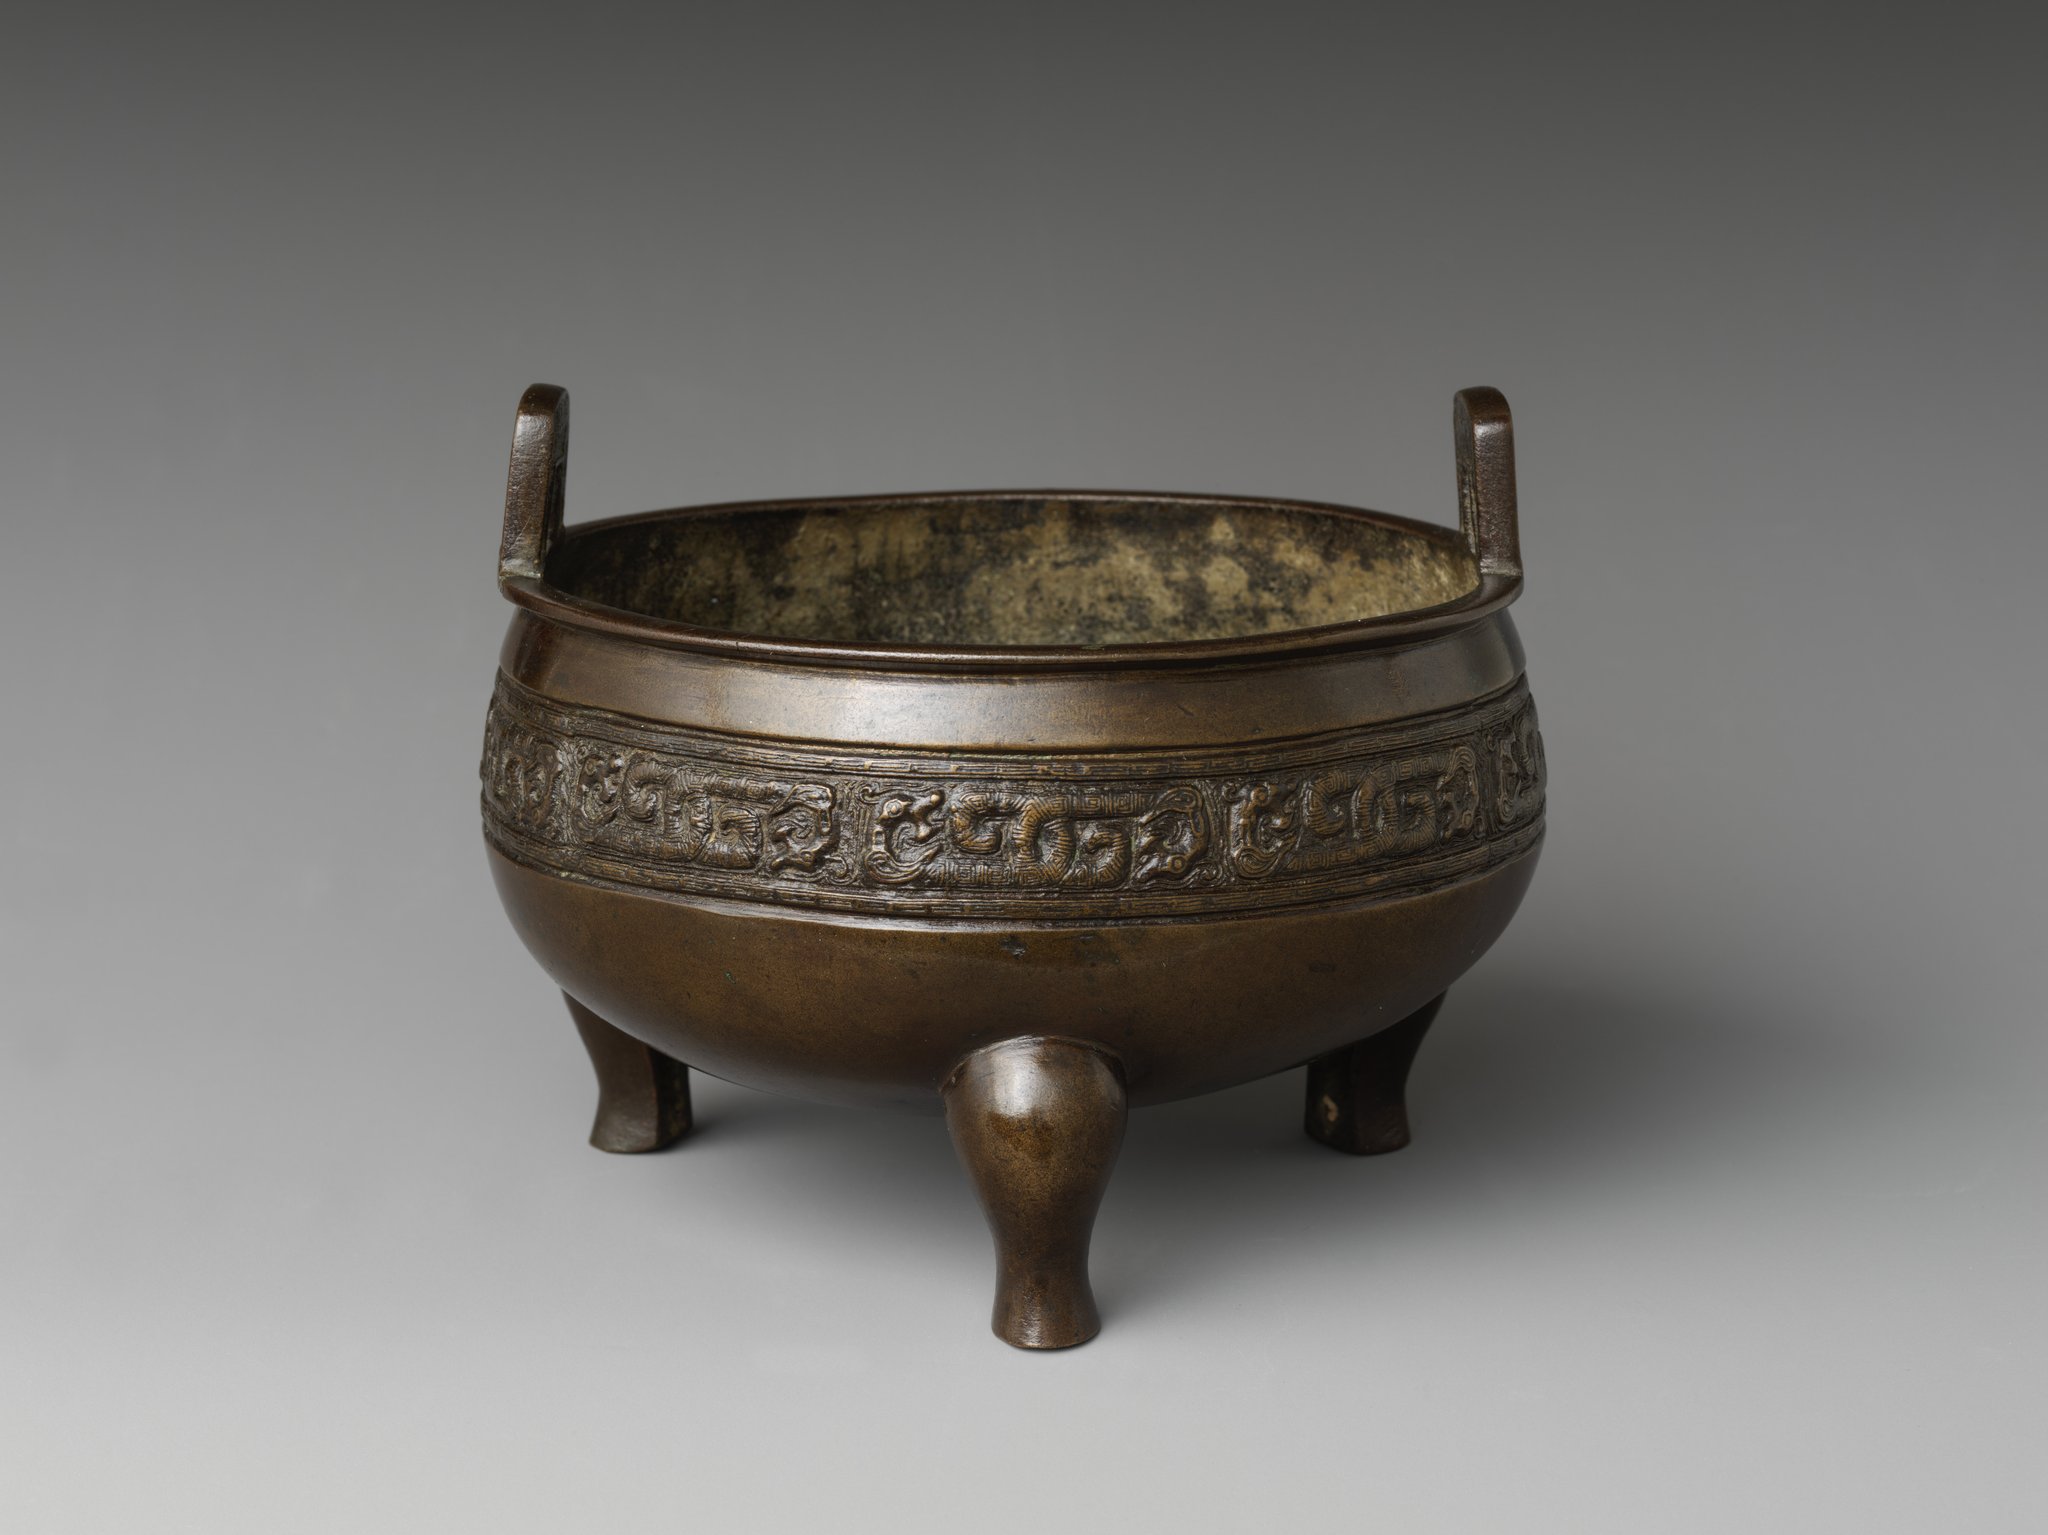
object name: censer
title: Tripod incense burner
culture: chinese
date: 1301-1400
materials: copper alloy